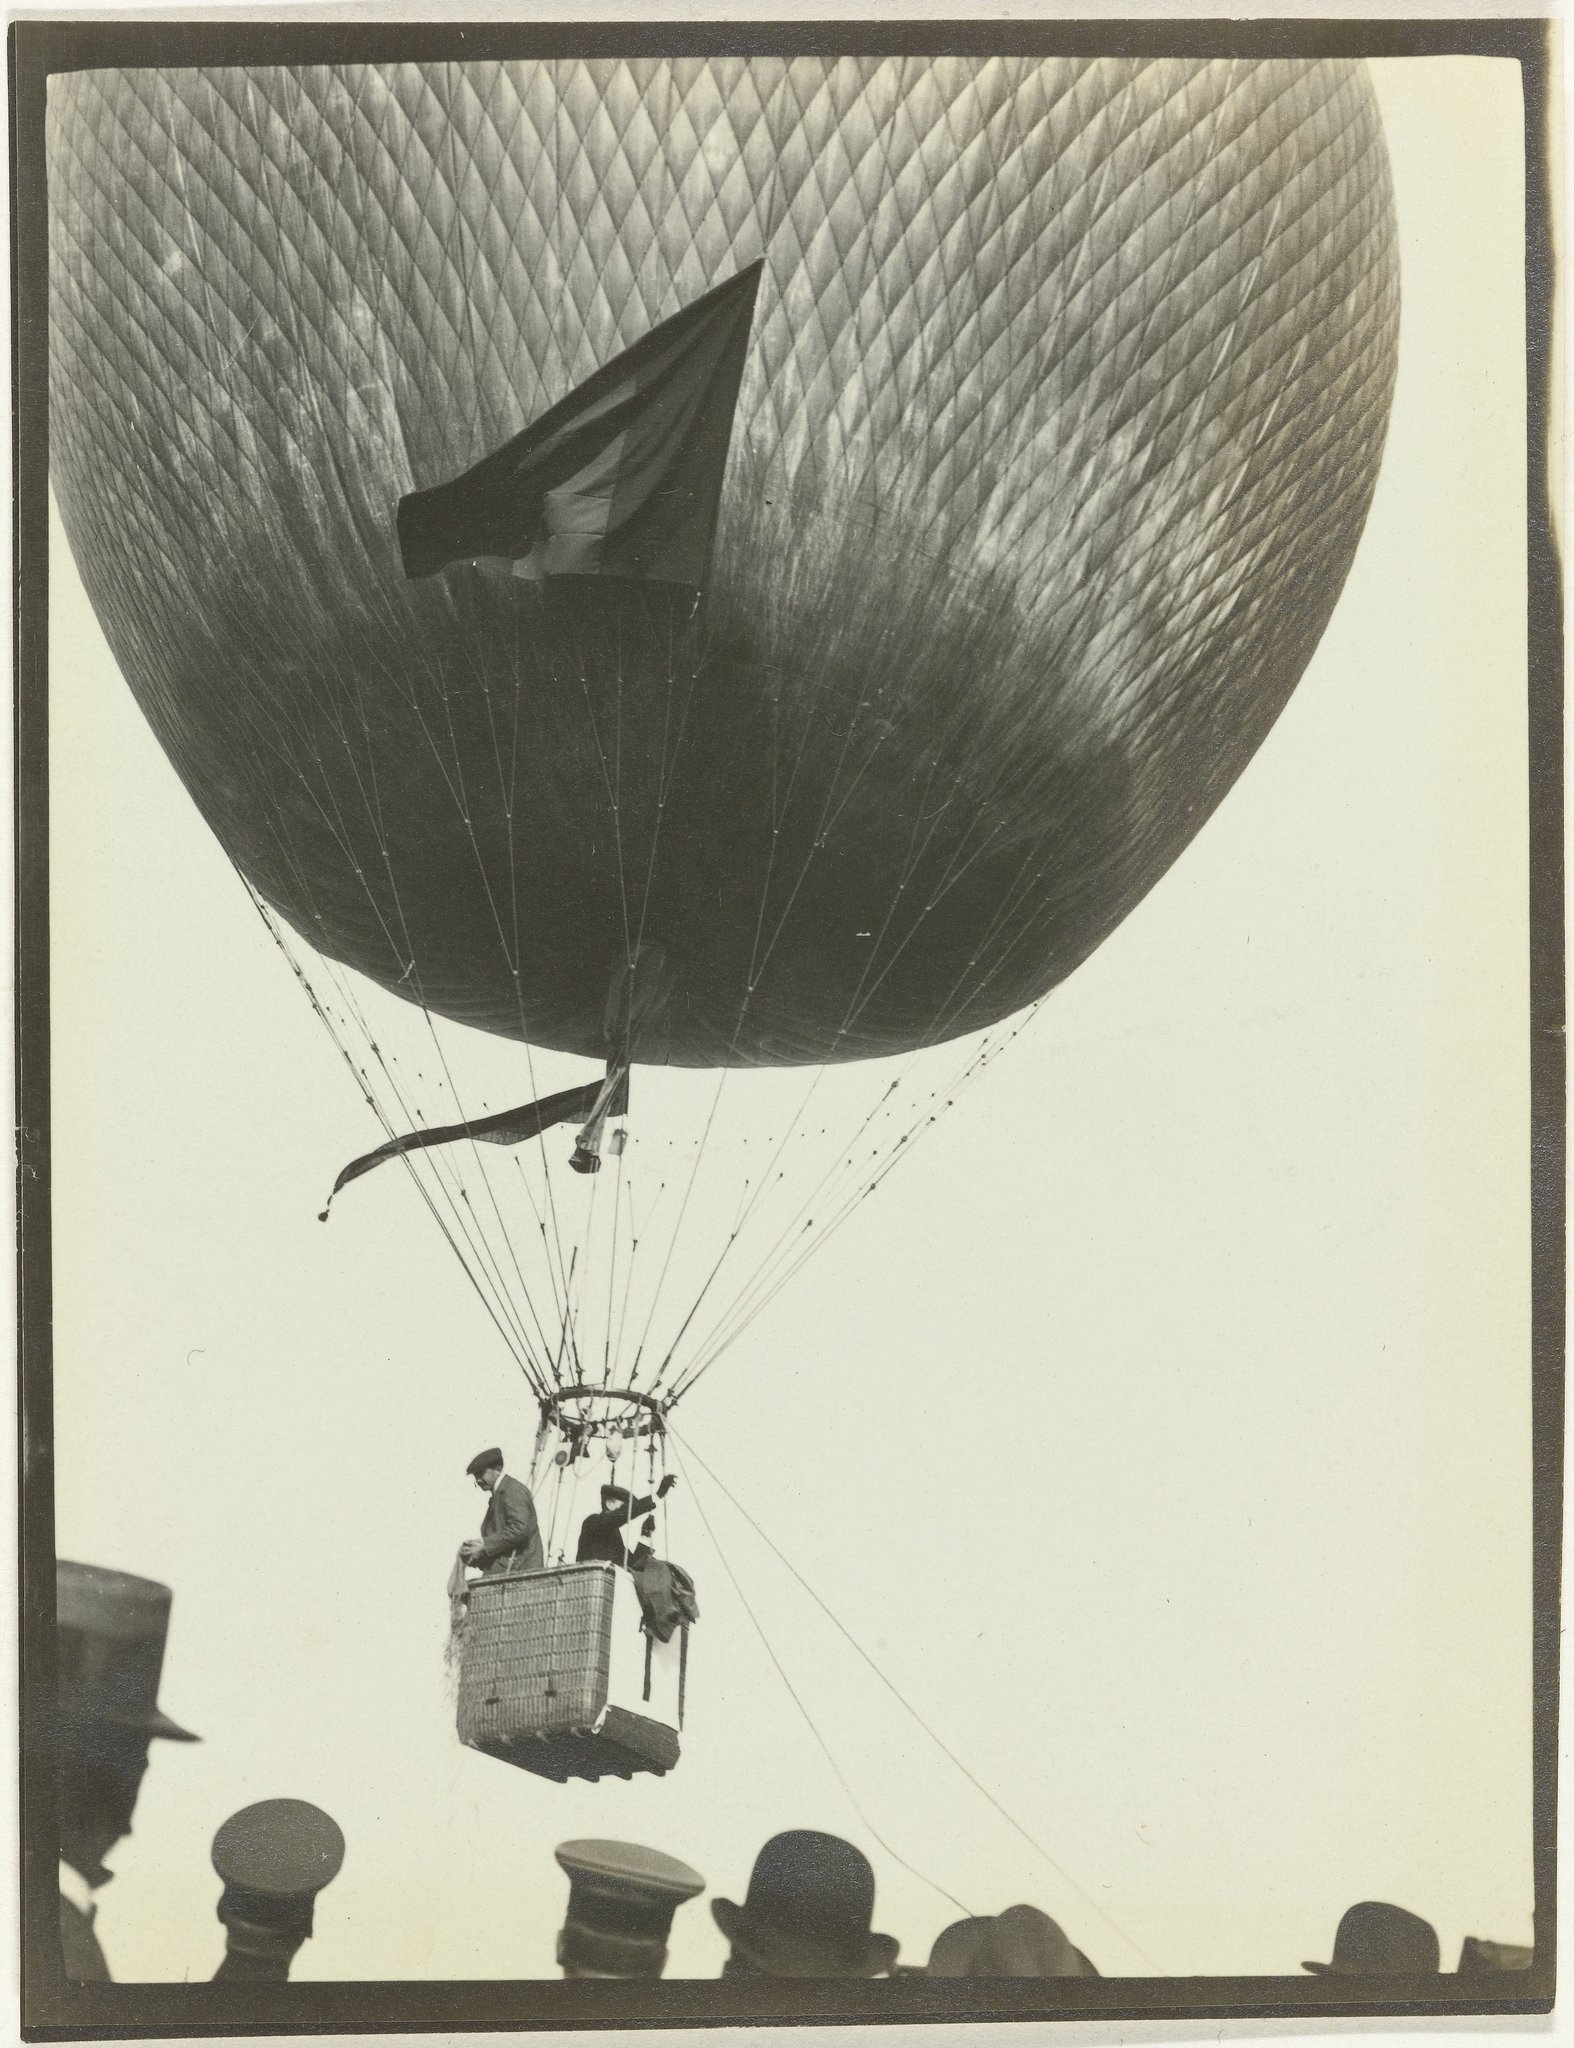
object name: photograph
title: The Third Gordon Bennett Balloon Race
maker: Anonymous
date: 1908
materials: paper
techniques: gelatin silver print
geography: schmargendorf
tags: (flying a) gas balloon, balloon flight (sport), balloon (aviation)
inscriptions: annotation: ‘L'Aéro III/ Belgien/ 37906/ 10/10/08 / Schmargendorf/ 10/10/08’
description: Opstijgende ballon met twee mannen in de mand. Op de voorgrond hoofden van toeschouwers.